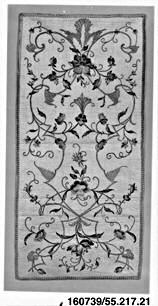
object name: panel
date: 1701-1800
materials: linen, metal thread, silk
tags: flowers